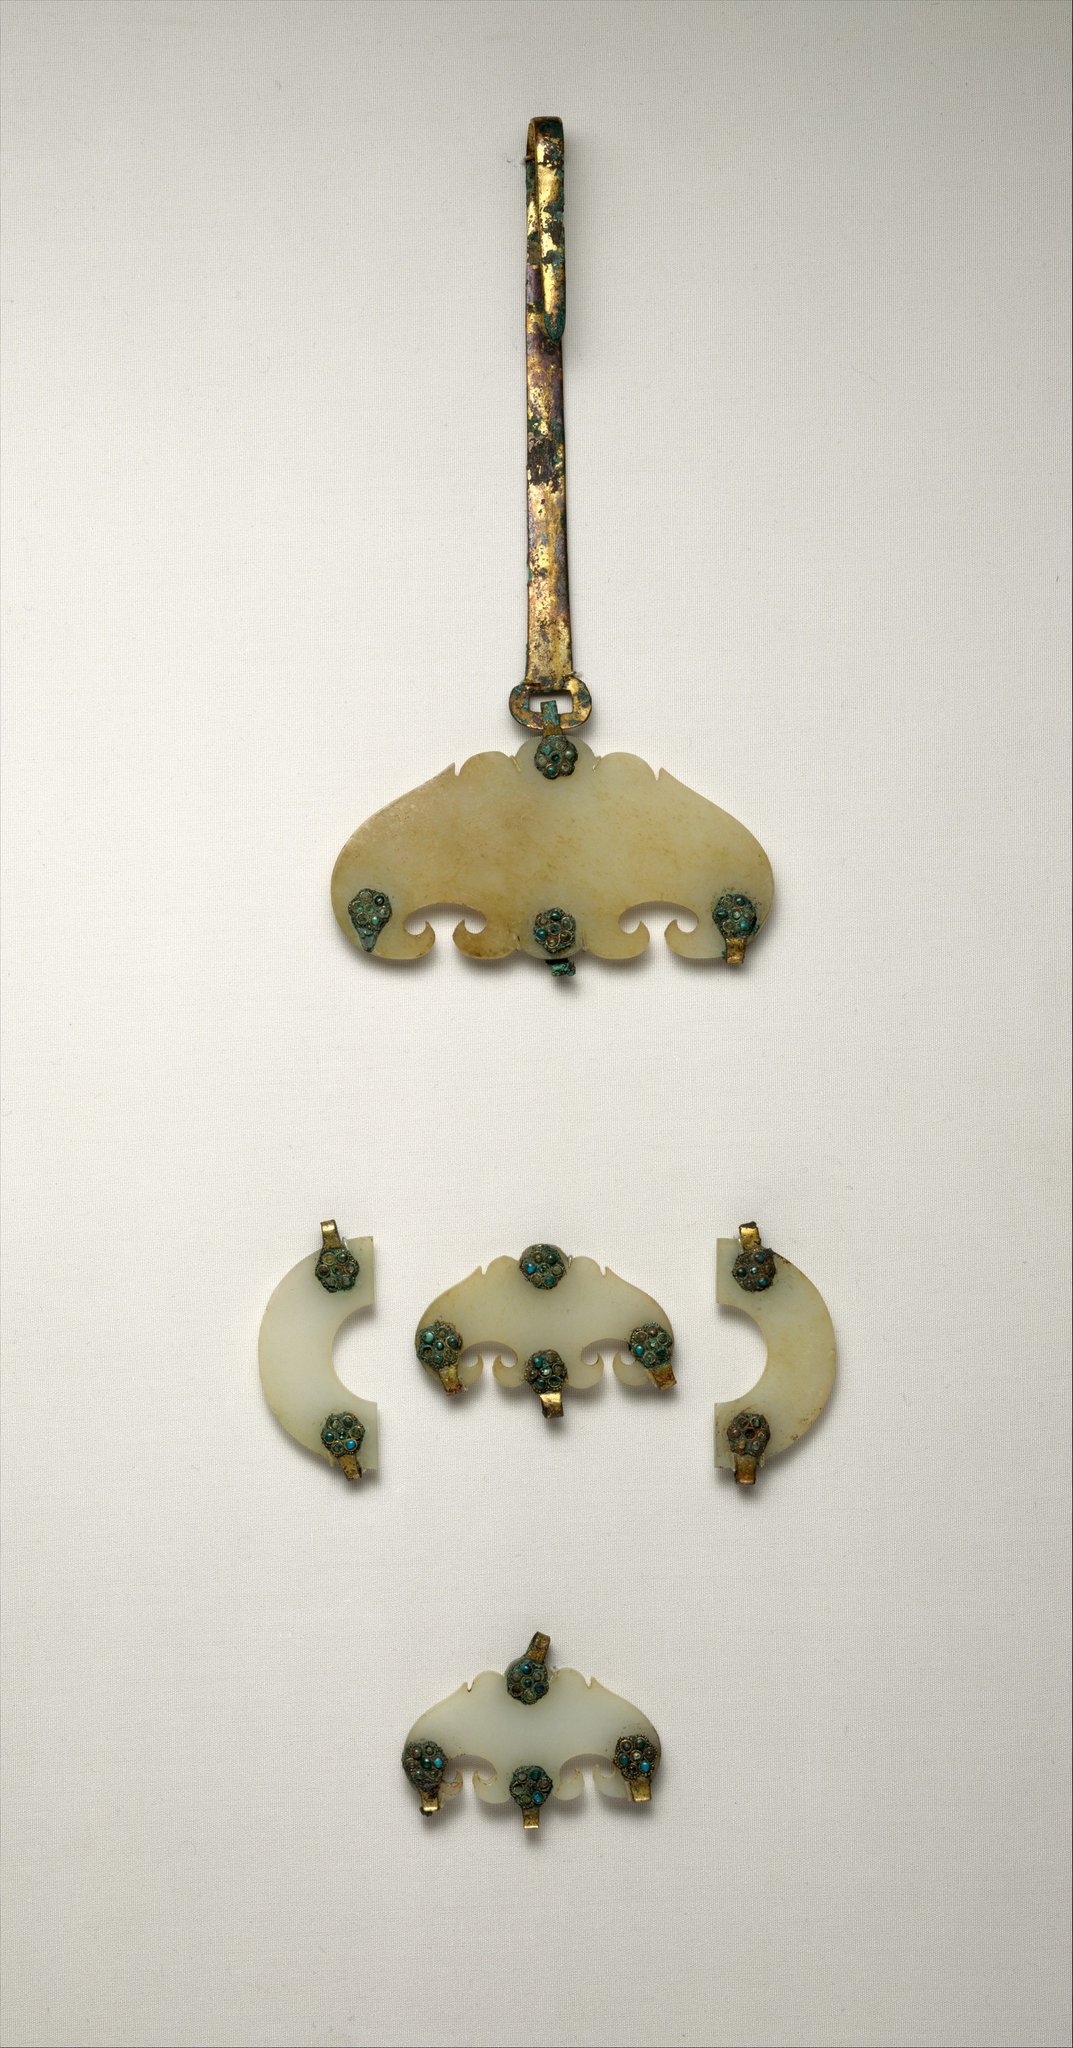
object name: plaque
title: Assemblage of pendants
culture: chinese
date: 701-733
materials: bronze, jade